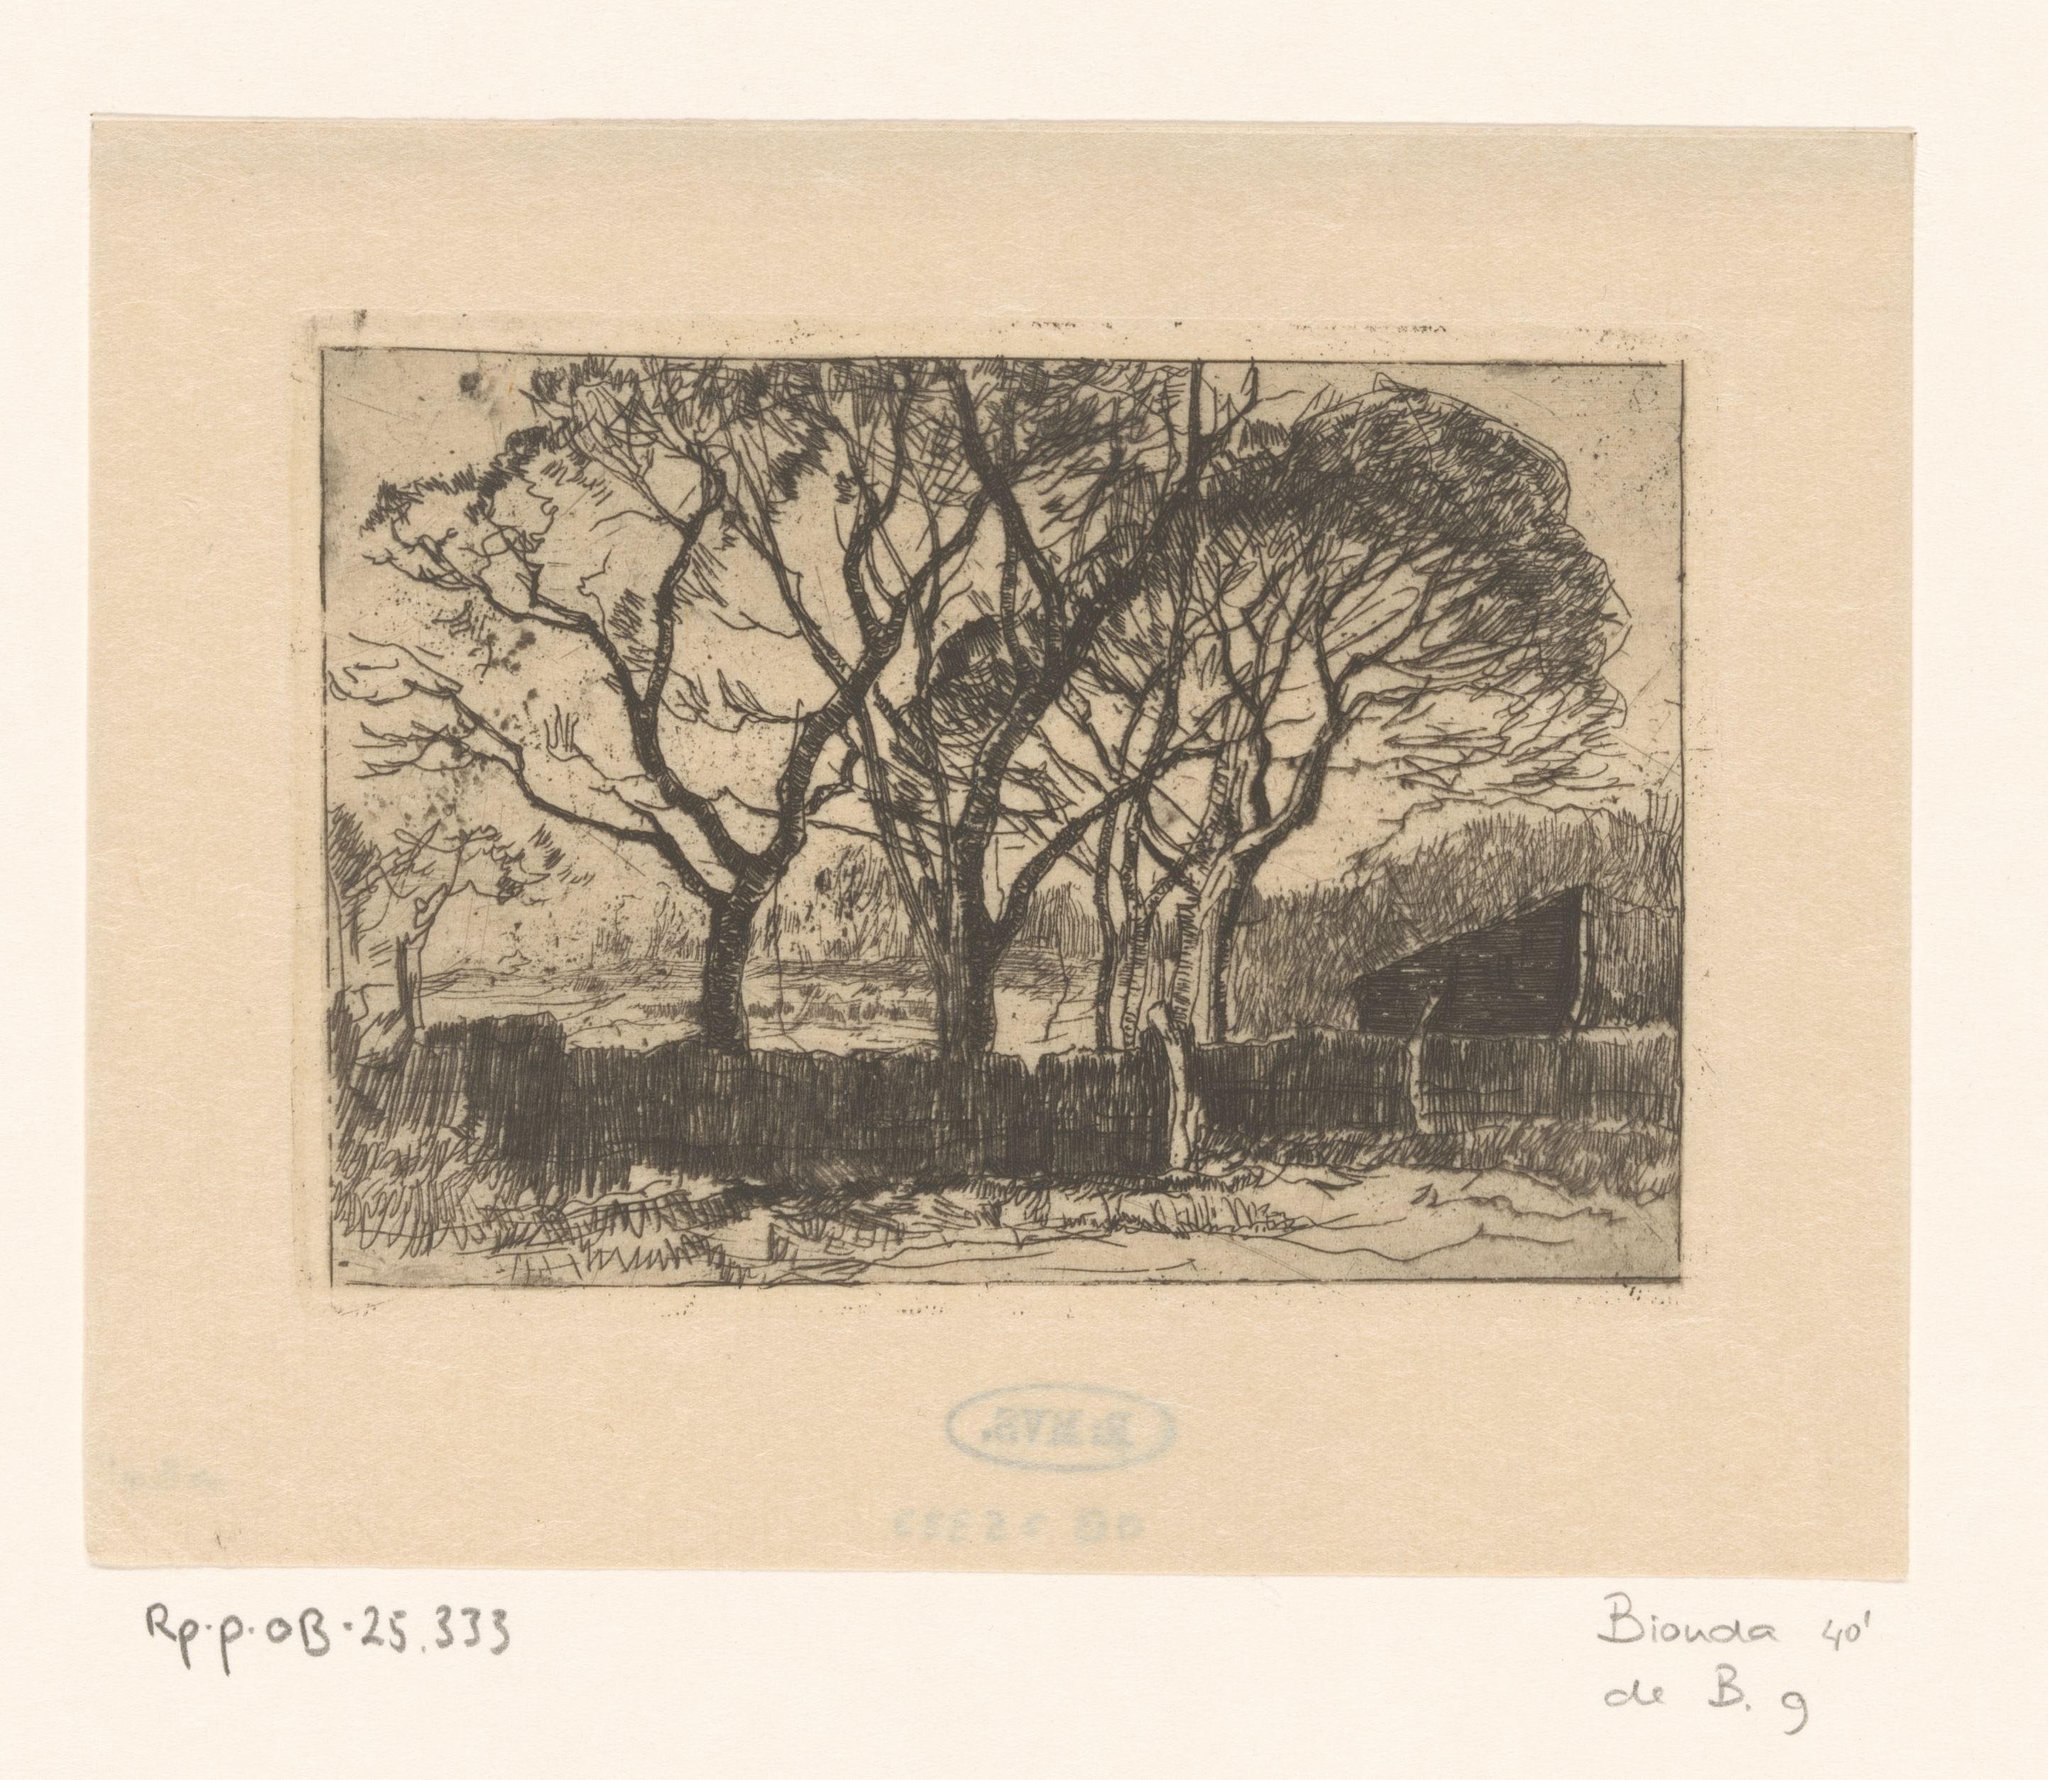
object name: print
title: Veld met bomen en een hek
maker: willem de zwart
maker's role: draughtsman, painter, print maker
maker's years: 1862-1931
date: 1889-1890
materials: paper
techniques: drypoint, etching, intaglio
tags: trees, fence, wall, paling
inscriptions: collector's mark: Lugt 2228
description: Prent verscheen in 1890 als onderdeel van de jaarlijkse uitgave van de 'Portefeuille der Nederlandsche Etsclub'.